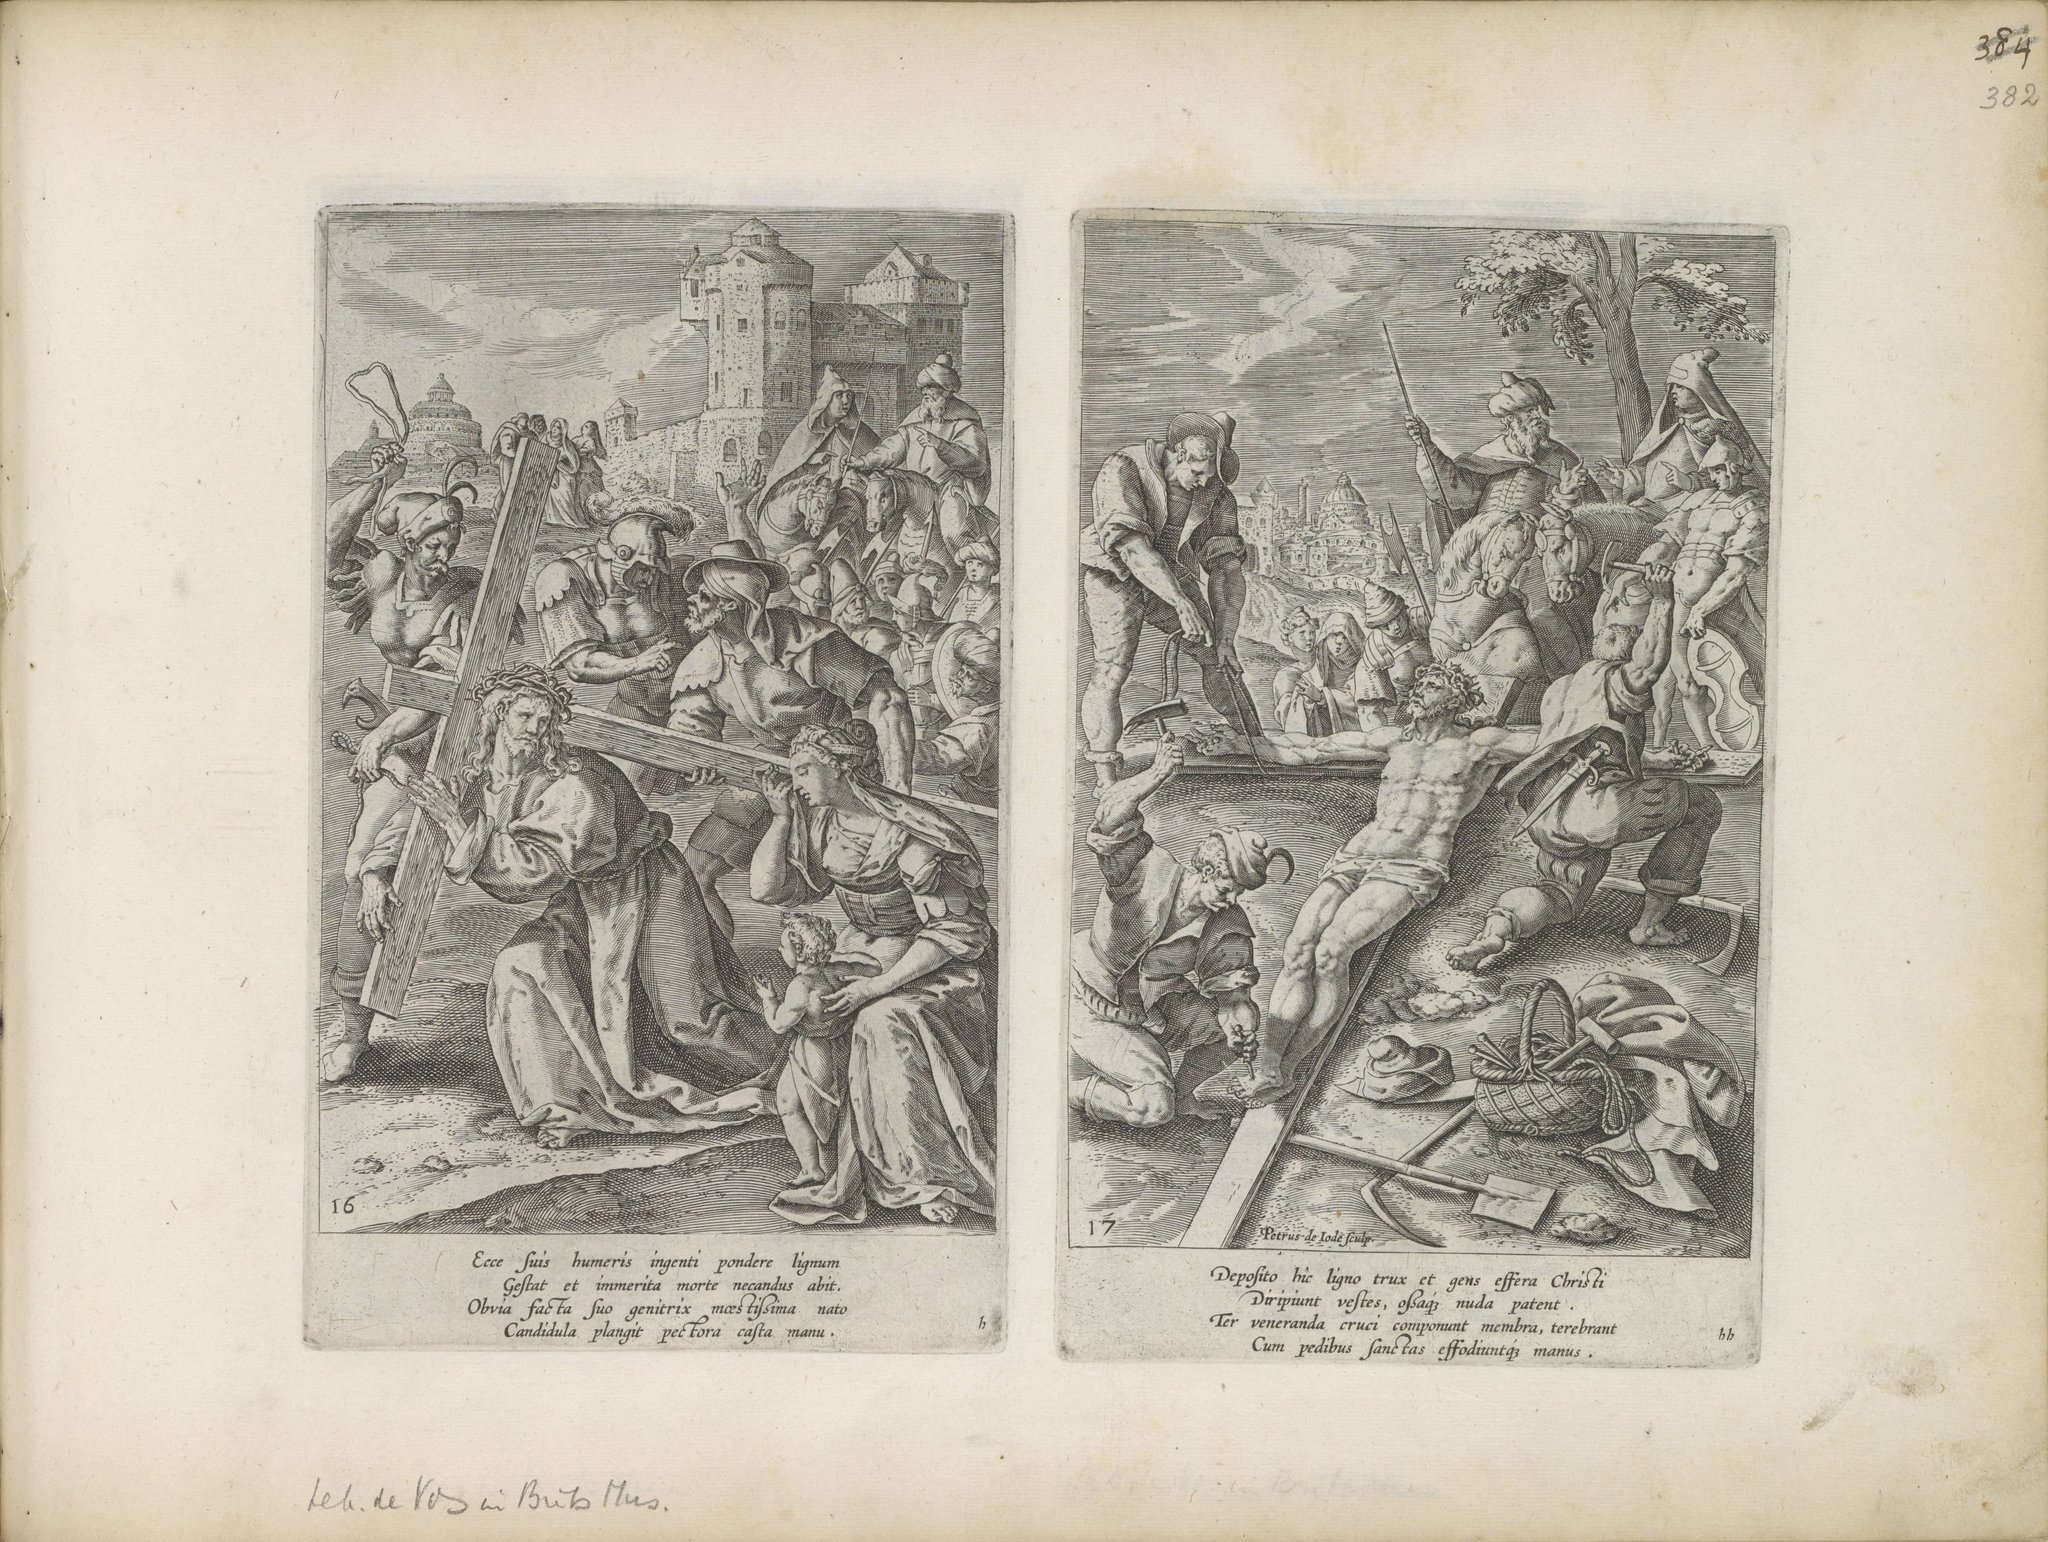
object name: album leaf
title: Kruisdraging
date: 1585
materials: paper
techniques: engraving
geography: amsterdam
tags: christ collapsing ~ carrying of the cross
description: Christus valt tijdens het dragen van zijn kruis naar Golgota. Simon van Cyrene helpt hem met het dragen van het kruis. Een Romeinse soldaat spoort hem aan om op te staan. Een vrouw en haar kleine kind kijken bedroefd toe. Onder de voorstelling een vierregelig vers in het Latijn. Rechtsonder de letter: h. Deze prent maakt deel uit van een album.